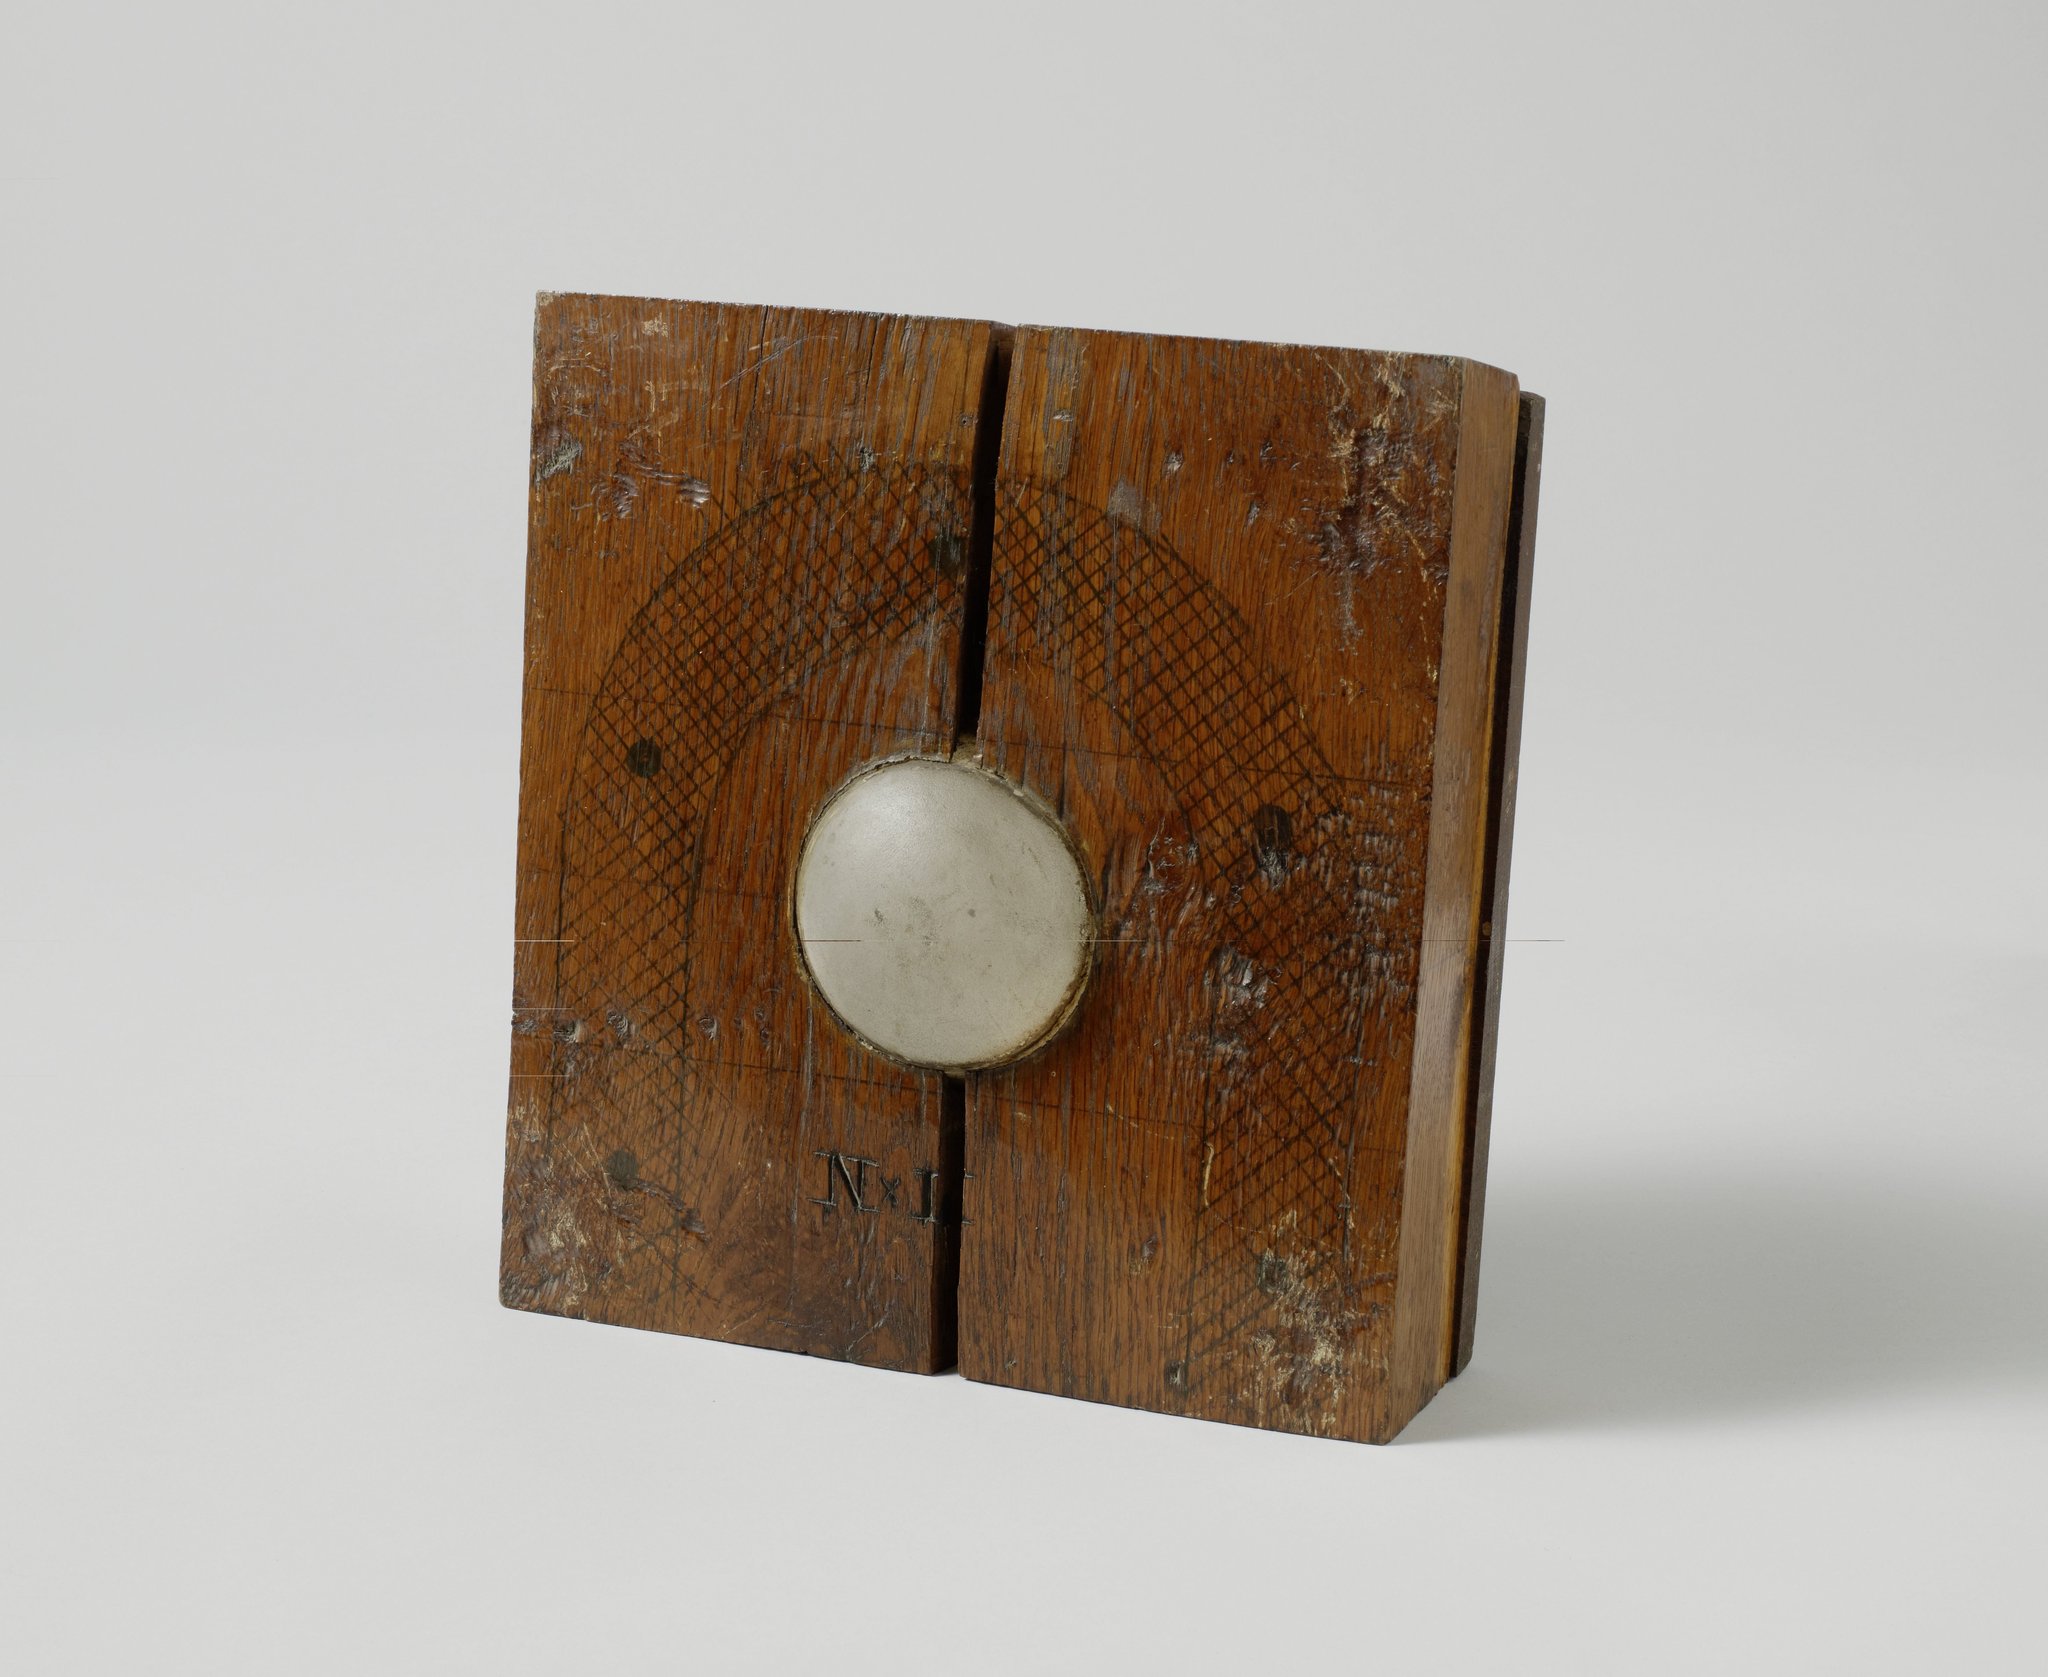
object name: portlight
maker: Anonymous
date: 1832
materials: cardboard, copper, glass, iron, putty, wood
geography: netherlands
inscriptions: inscription, on the side: ‘Bove’, inscription, below the glass: ‘Nx 1’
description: Deze modellen MC-236 t/m 238 vormen samen waarschijnlijk de serie modellen die besteld werden op grond van het voorstel van P. Schuijt, P. Glavimans Jz. en C. Soetermeer van 1832 voor glazen patrijspoorten in een bovenhoek van de geschutpoorten van linieschepen. Hun voorstel was geïnspireerd op het voorbeeld van de Waterloo (zie NG-MC-235) en volgde op hun beoordeling van de twee lichtglazen van P. Schuijt jr. (NG-MC-238-1 en NG-MC-238-2). Het glas van NG-MC-237-1 is waarschijnlijk identiek aan dat door P. Schuijt jr. voorgesteld (NG-MC-238-2).